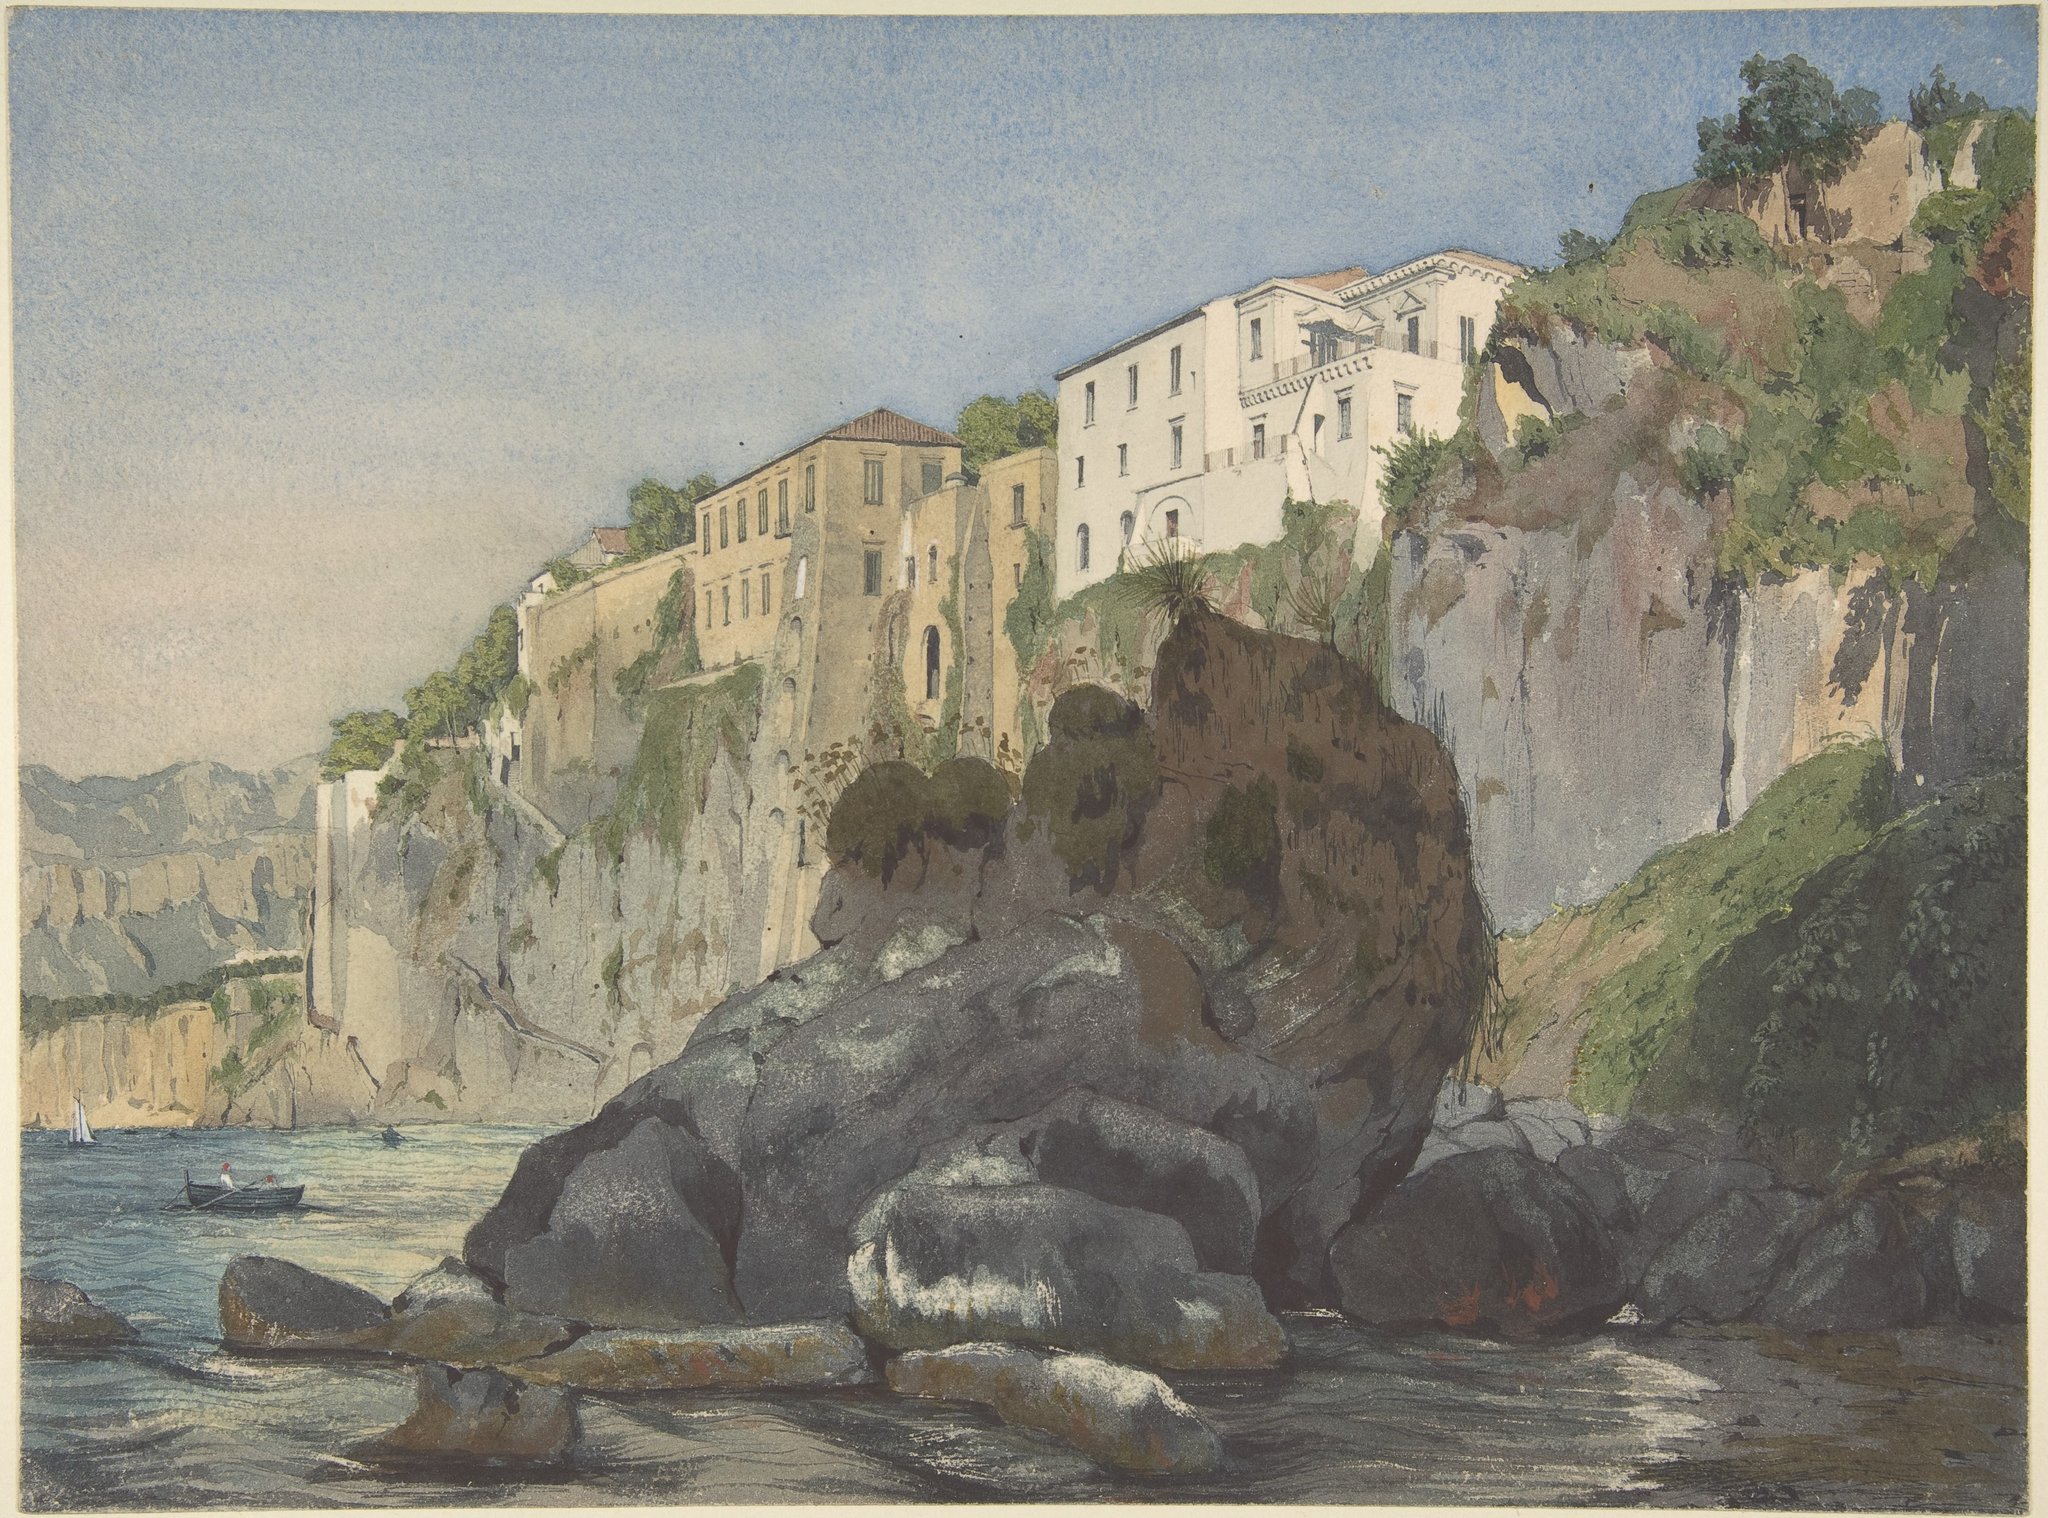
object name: drawing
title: Houses at Sorrento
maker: thomas hartley cromek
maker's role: artist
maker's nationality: british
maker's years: 1809-1873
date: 1834-1866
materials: gouache, graphite, watercolor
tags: houses,rivers